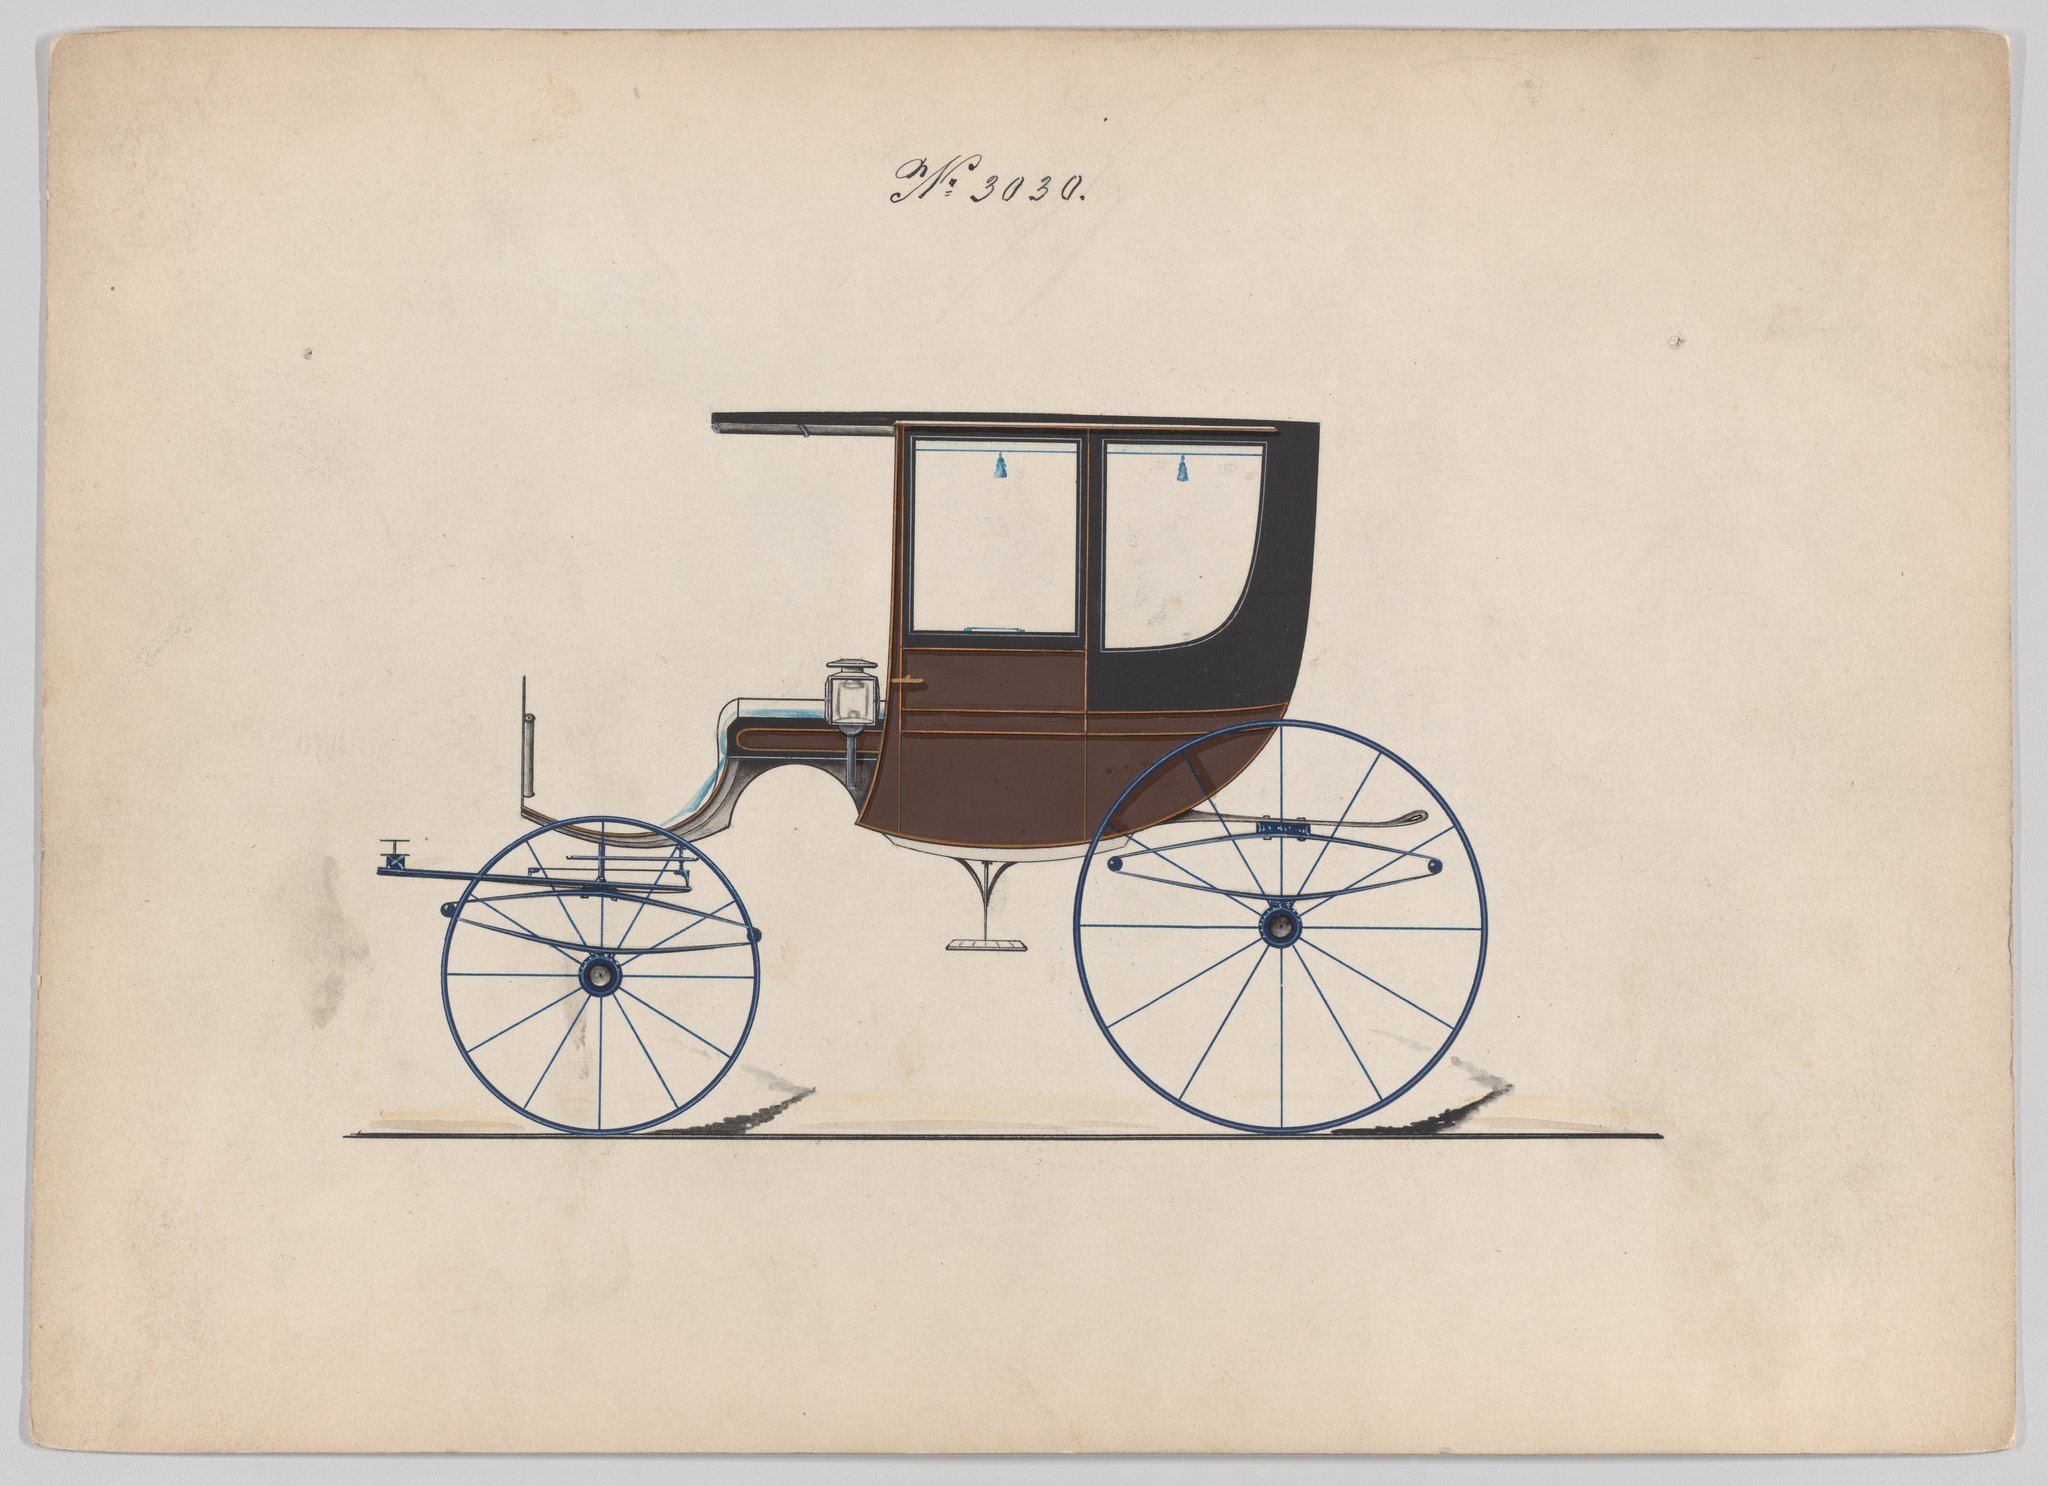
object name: drawing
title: Design for 4 seat Rockaway, no. 3030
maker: brewster & co.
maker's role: manufacturer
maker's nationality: american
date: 1874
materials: gouache, gum arabic, ink, watercolor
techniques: pen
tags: carriages